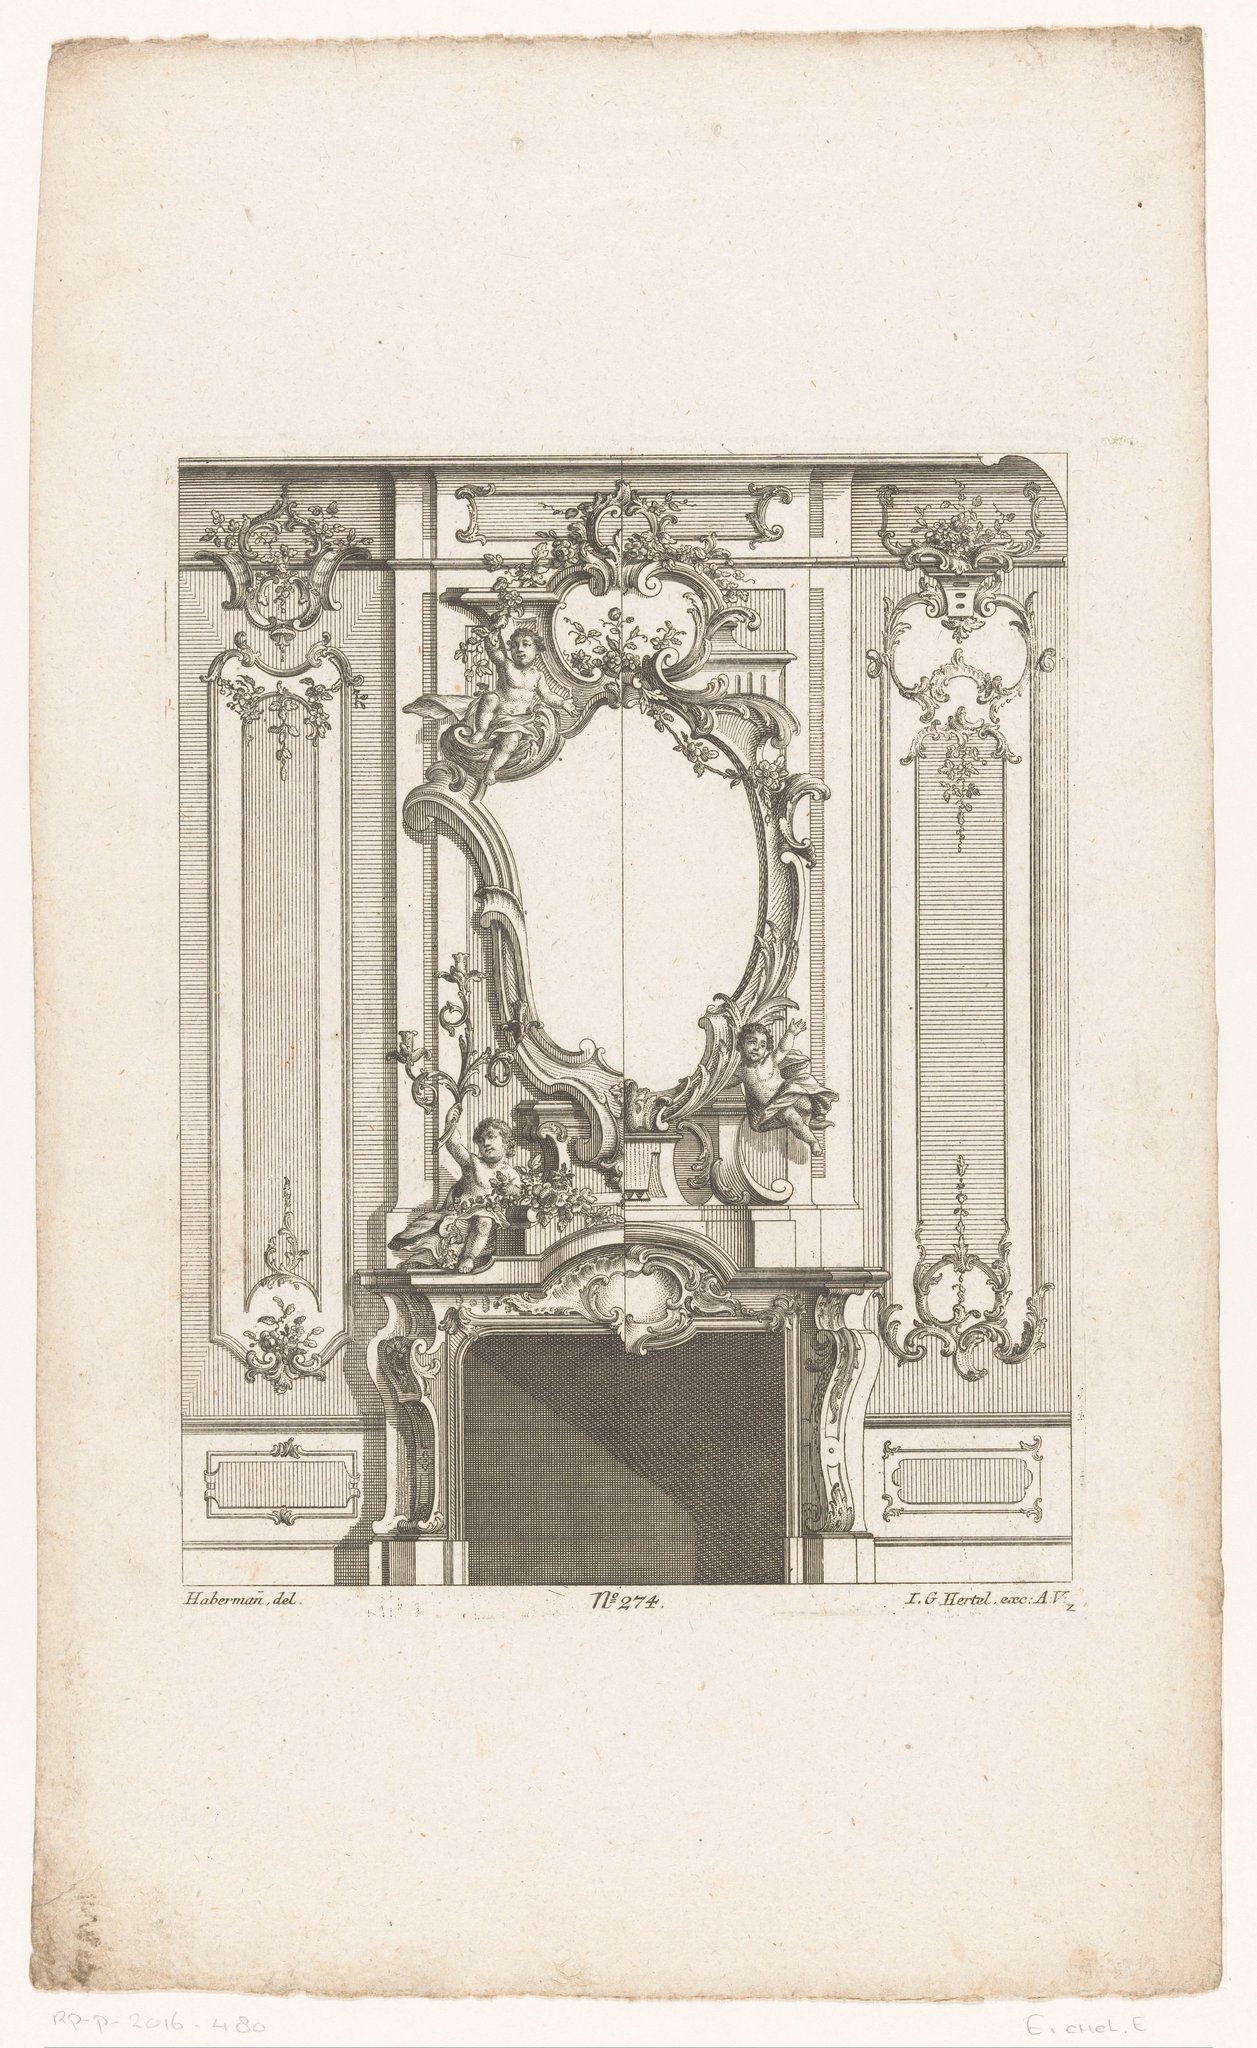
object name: print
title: Schouwen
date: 1746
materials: paper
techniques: engraving, etching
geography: augsburg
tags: open hearth, fire-place, cupids: 'amores', 'amoretti', 'putti'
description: Schouw met rocaille ornamenten, bloemmotieven, drie putti en een driearmige kandelaar. Uitgeversnummer 274.